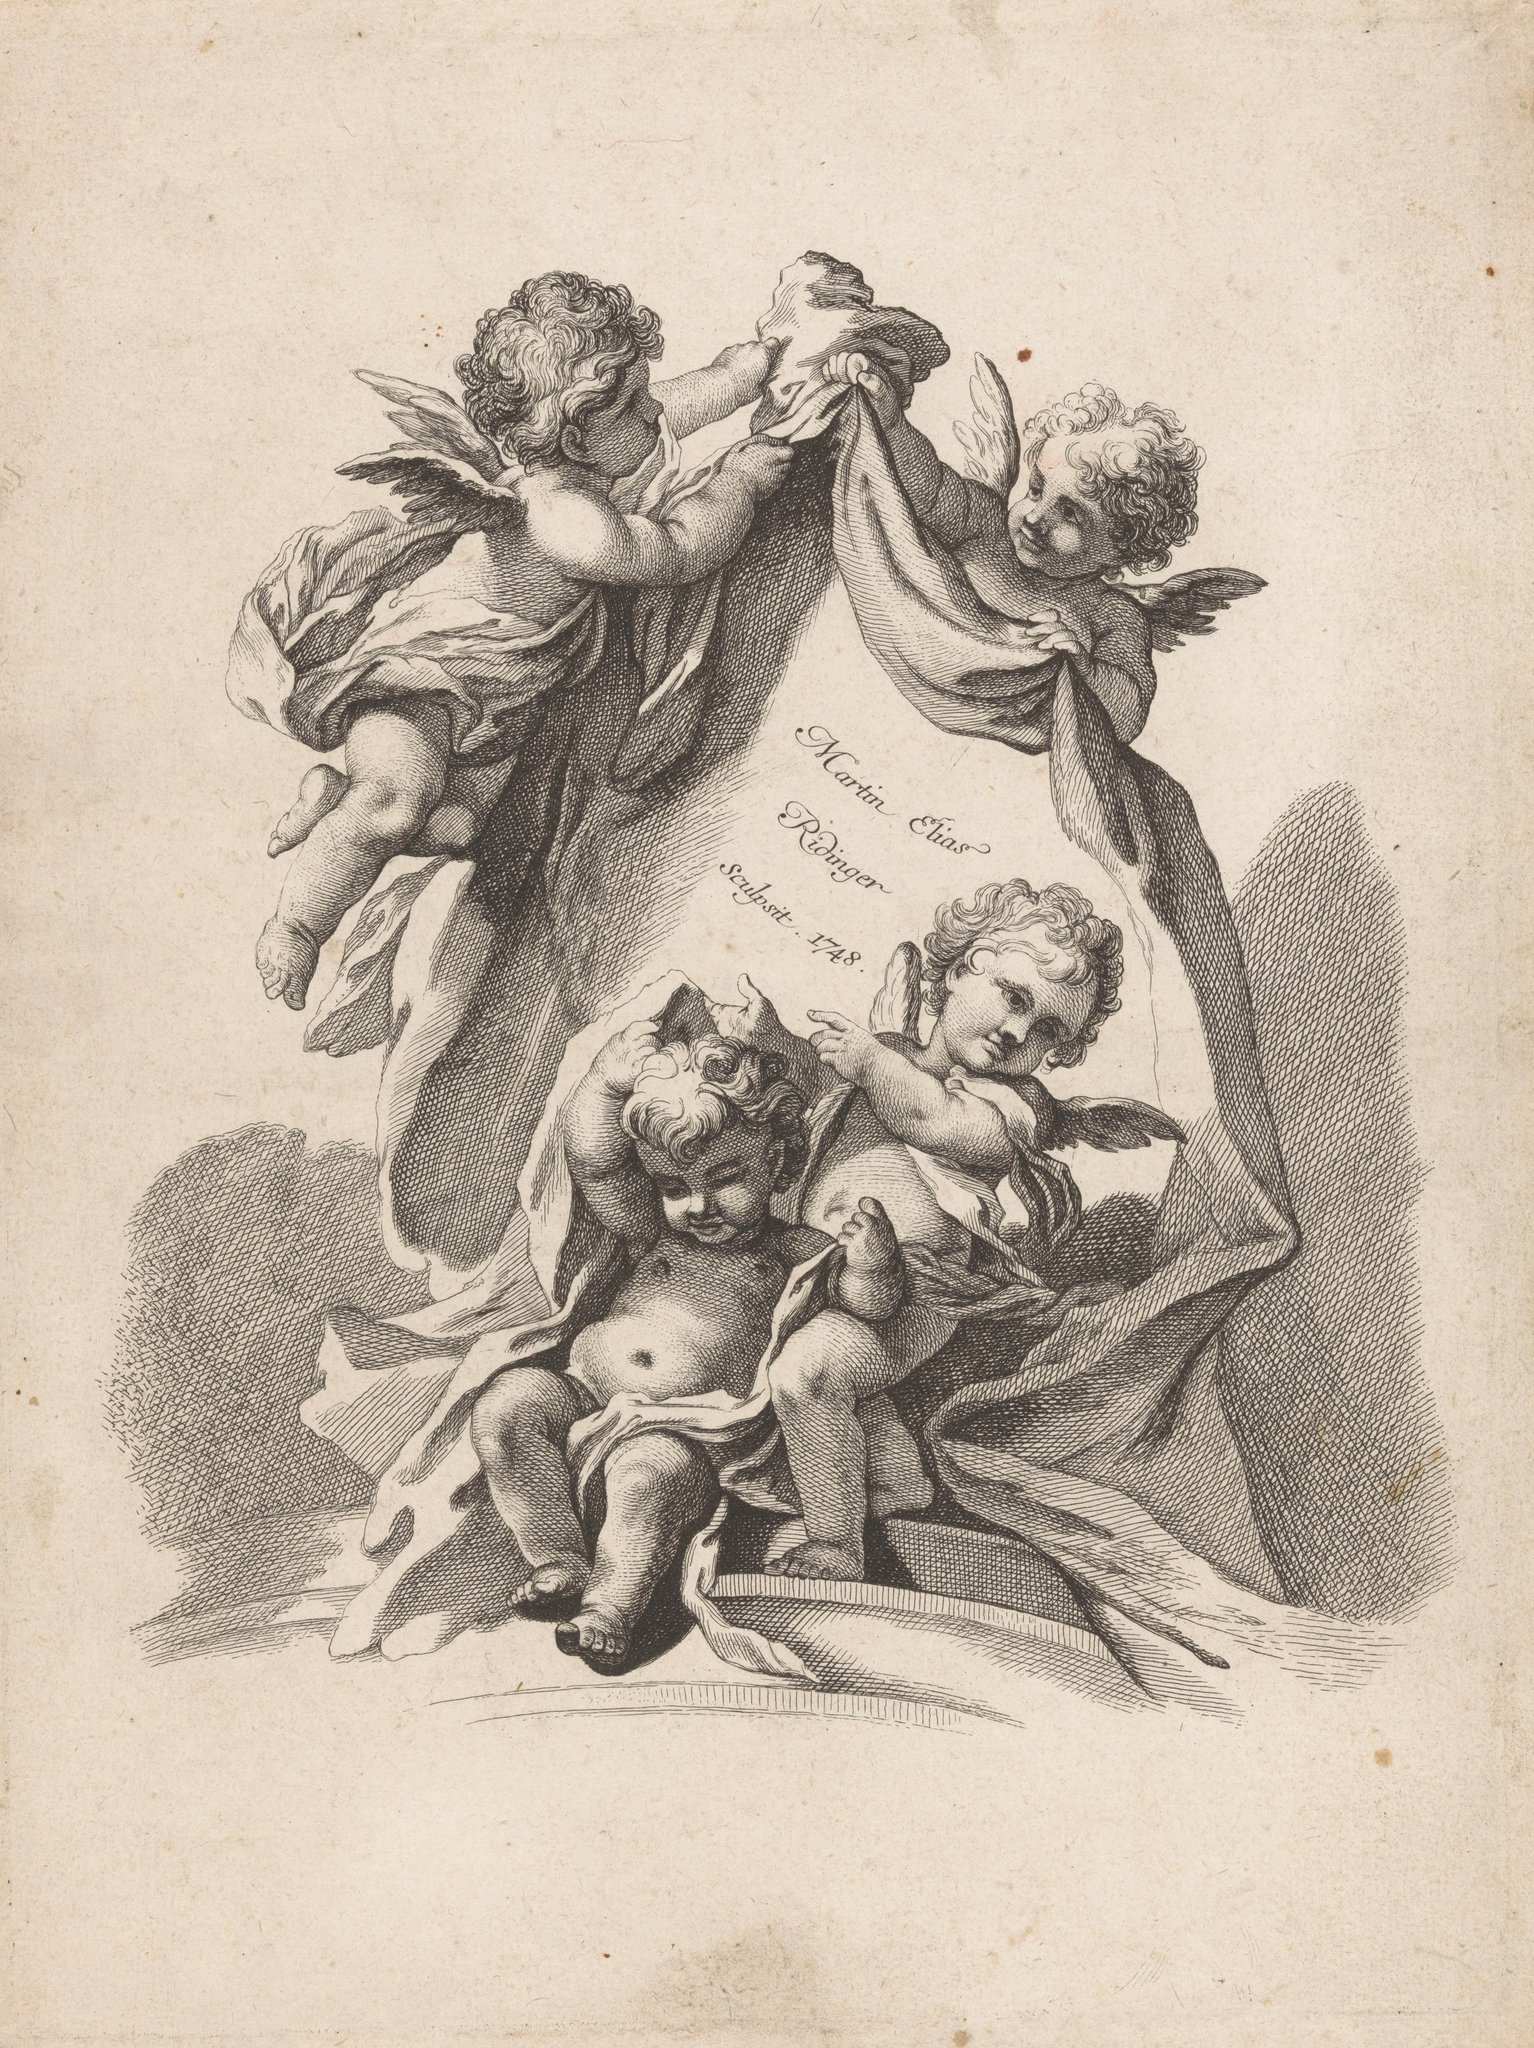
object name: ornament print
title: Vier putti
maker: martin elias ridinger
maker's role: print maker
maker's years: 1730-1780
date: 1748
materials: paper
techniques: engraving, etching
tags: cupids: 'amores', 'amoretti', 'putti'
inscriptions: collector's mark: Lugt 2228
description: Kopie naar Premier Livre de Groupes d'Enfans van François Boucher.